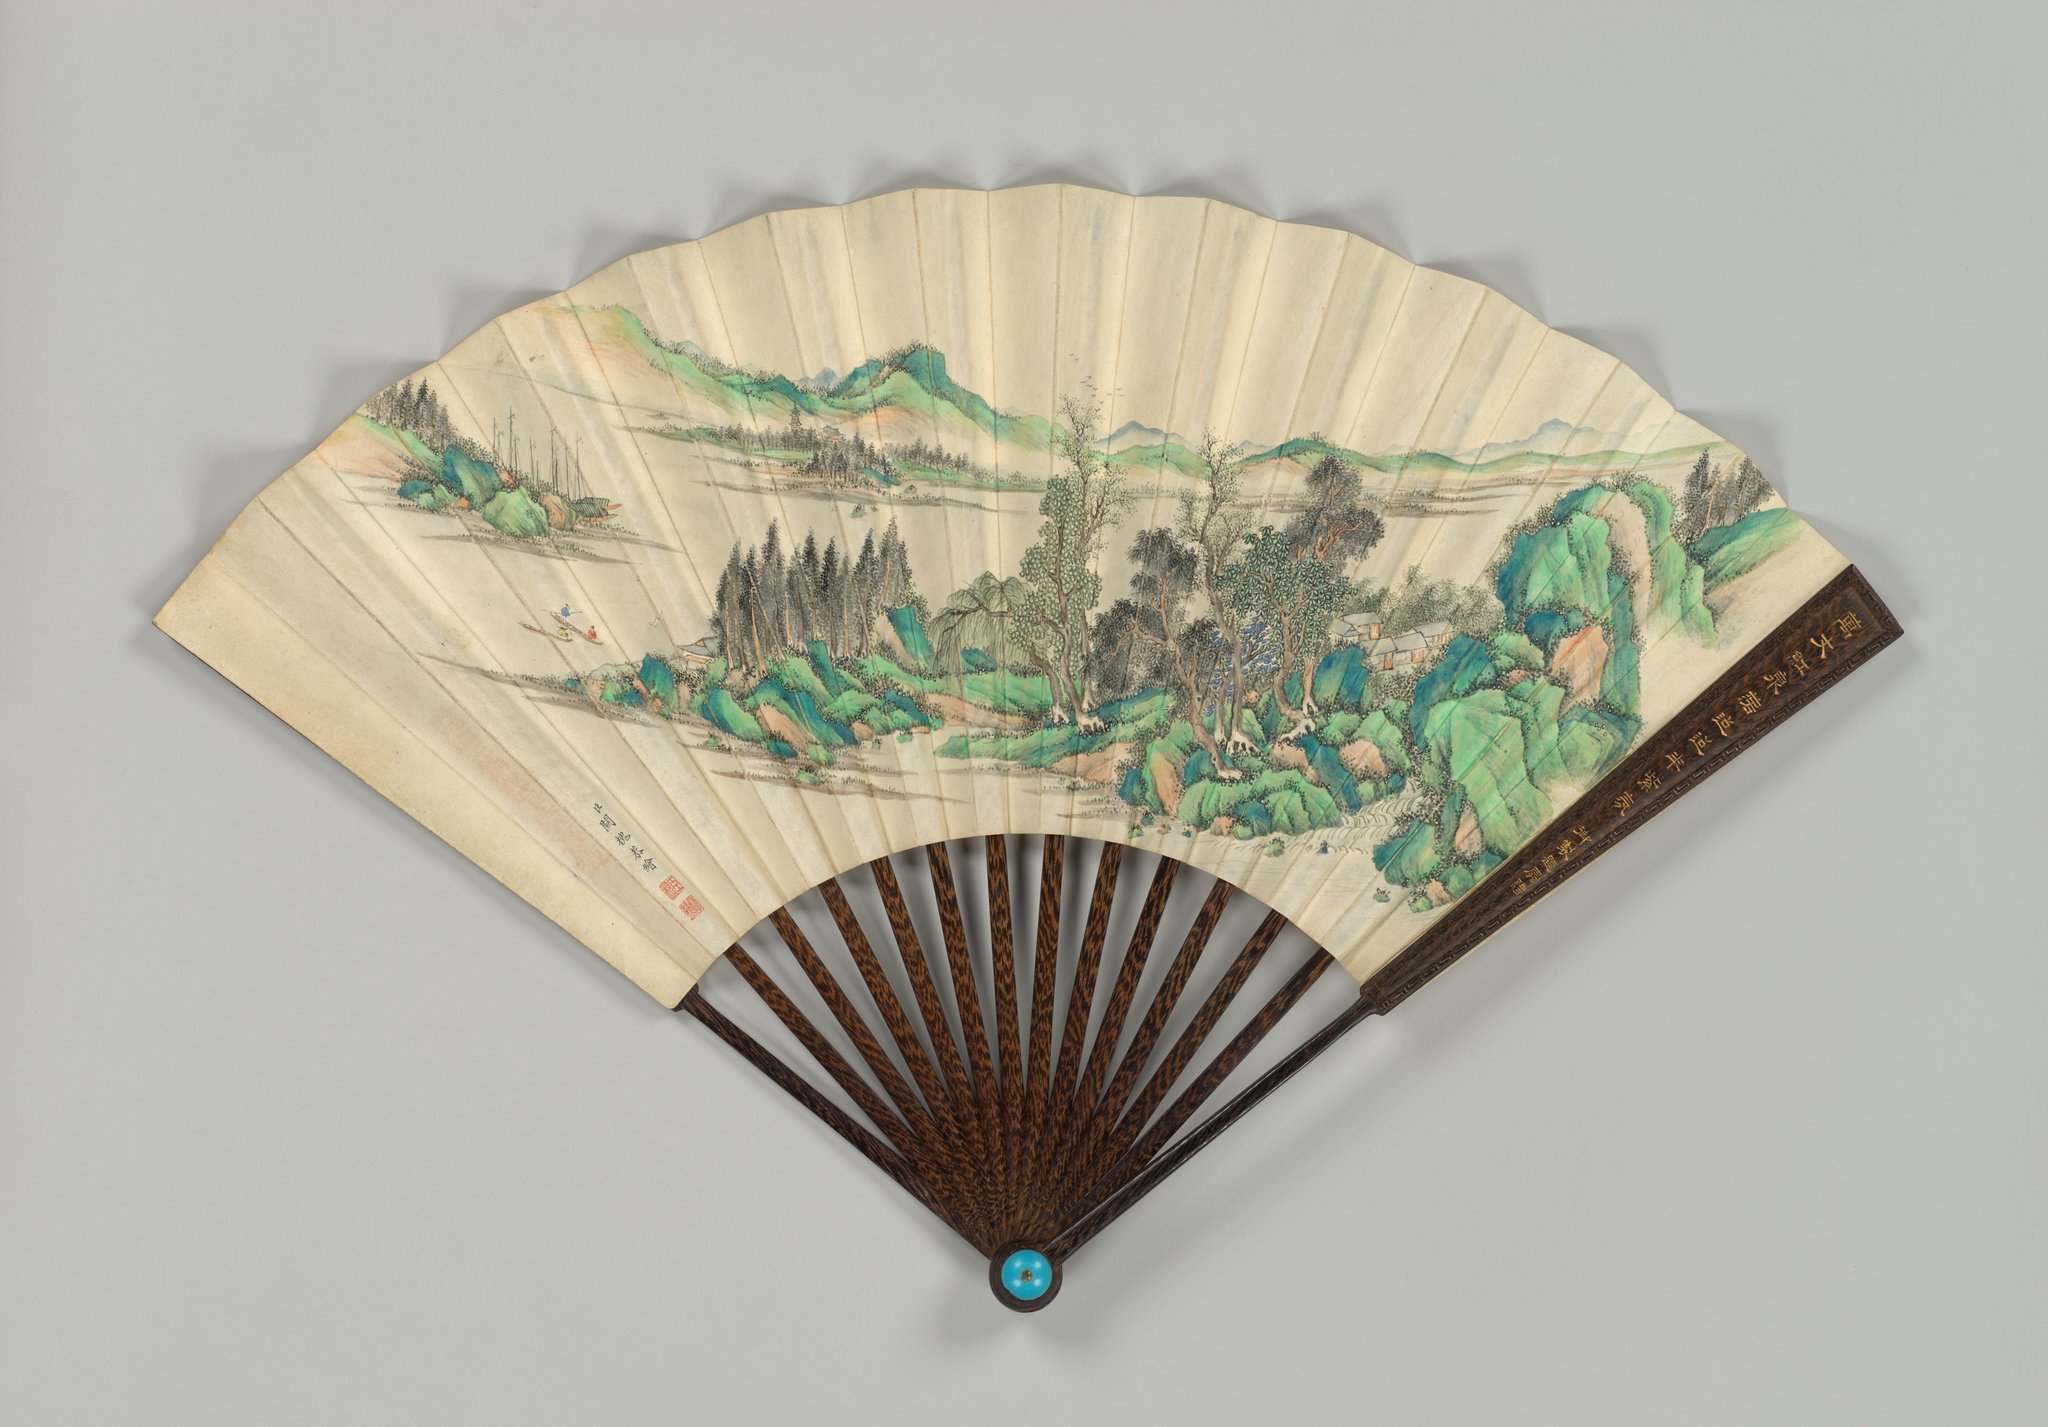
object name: fan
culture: chinese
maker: unidentified artist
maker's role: artist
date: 1736-1795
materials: paper